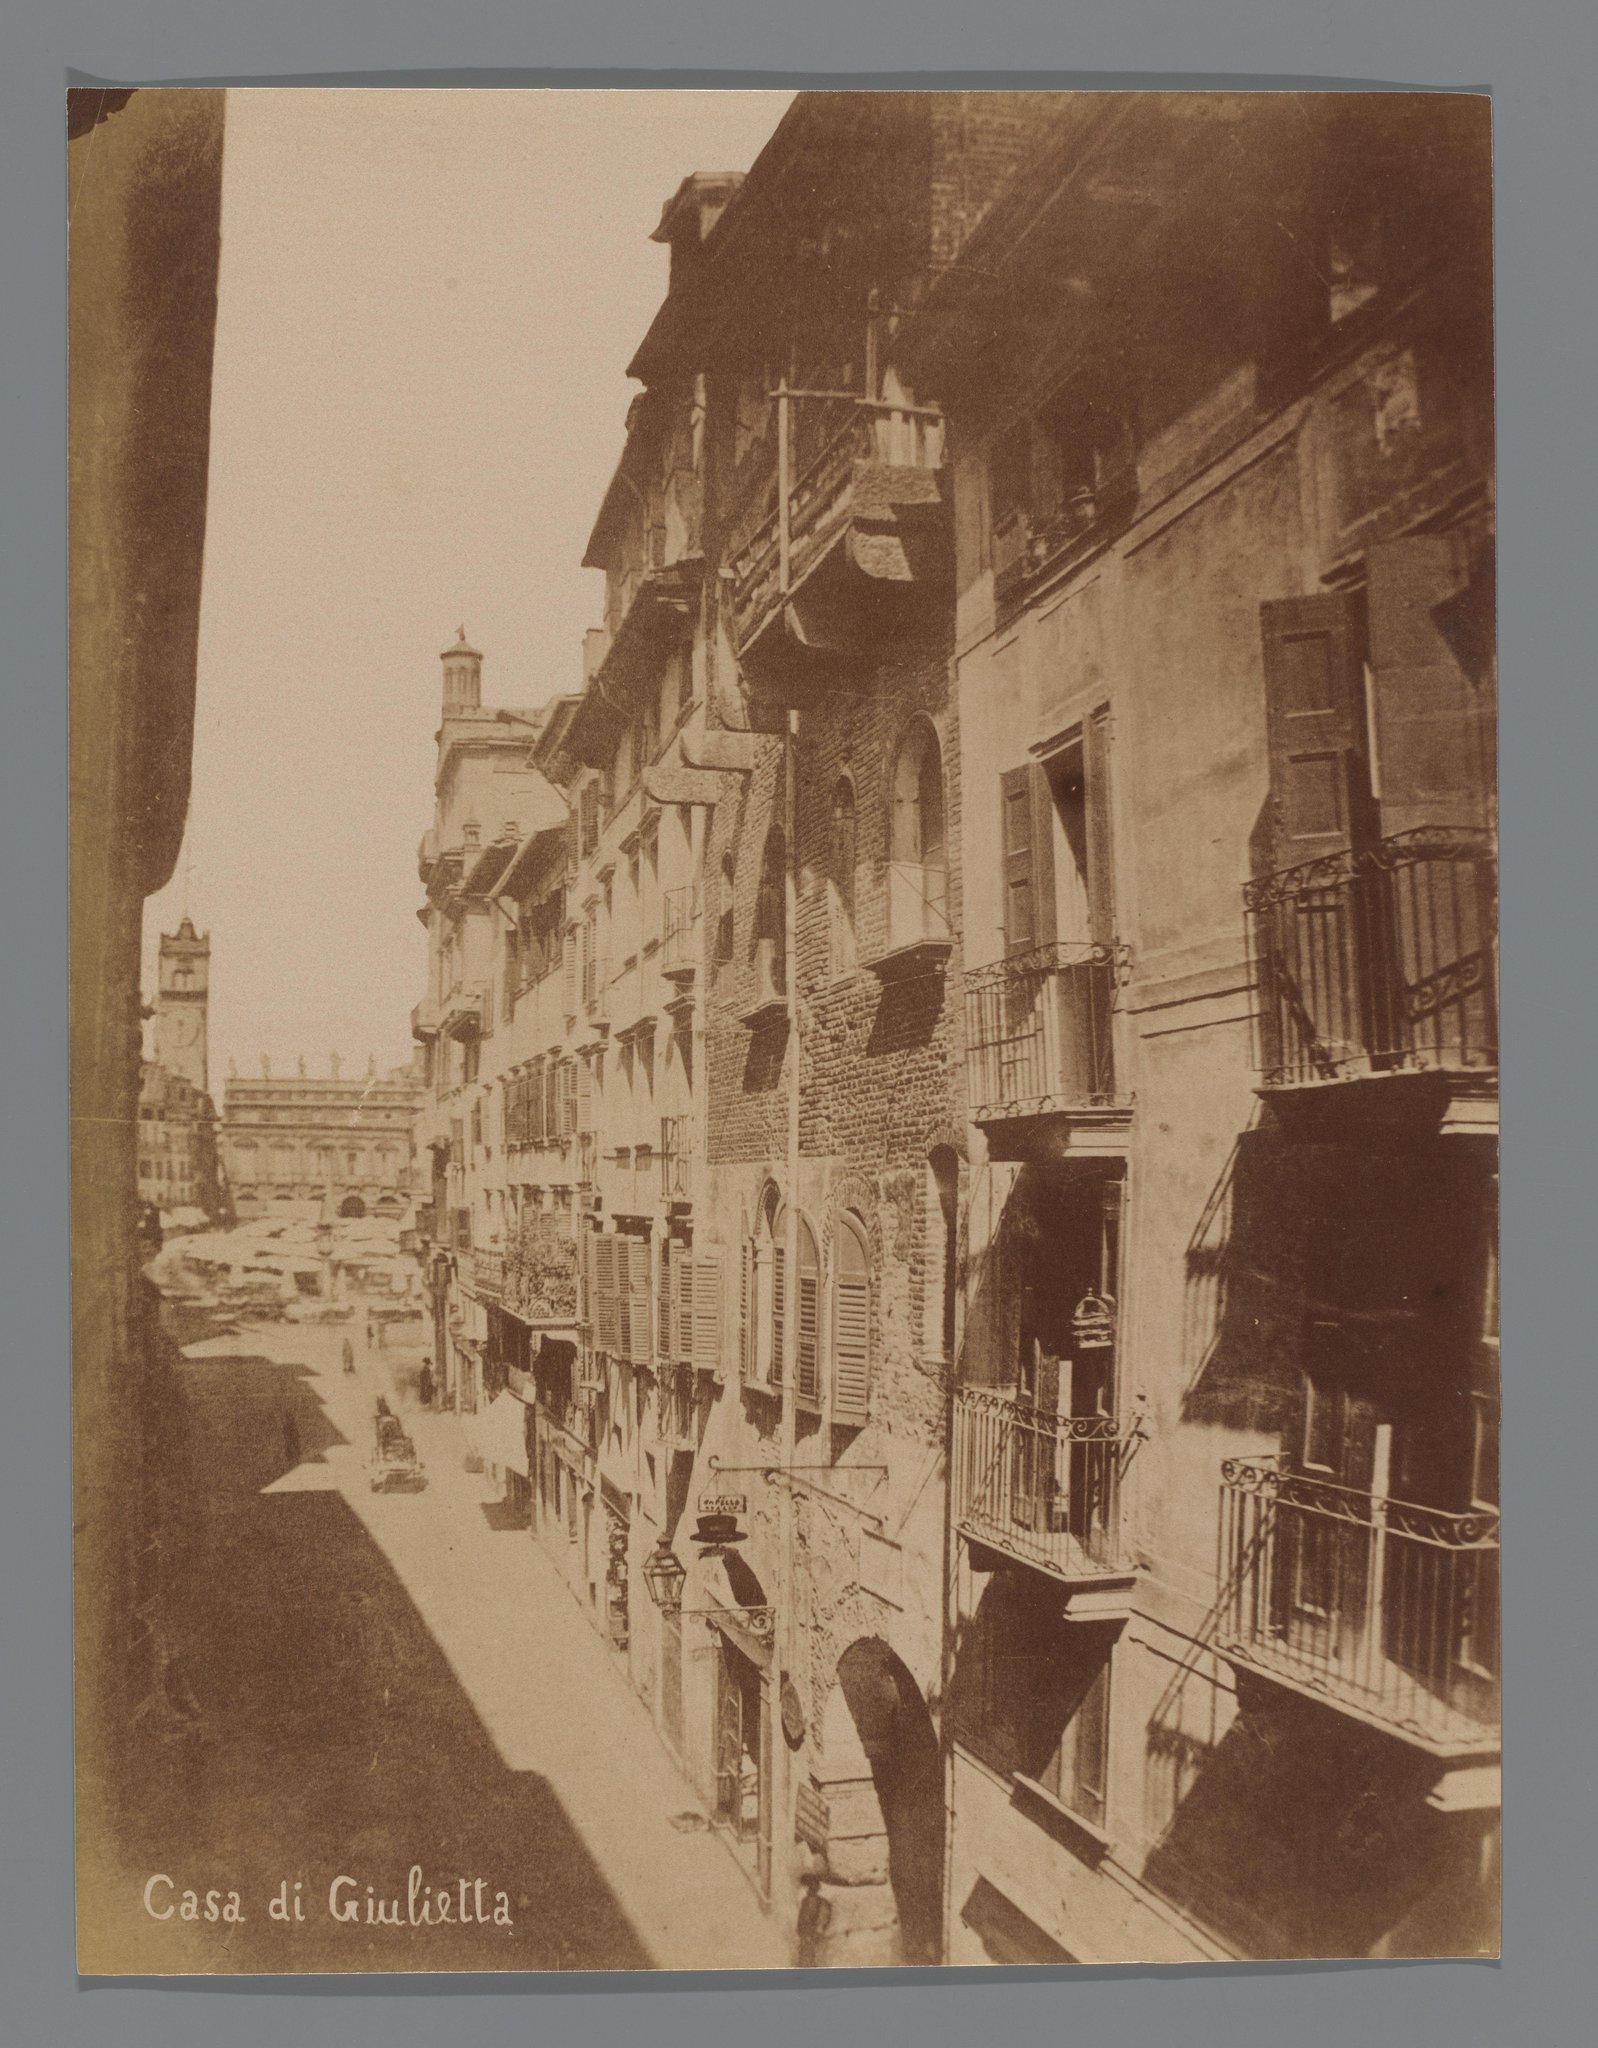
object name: photograph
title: Zicht in de Via Cappello met het huis van Julia te Verona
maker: Anonymous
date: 1851-1900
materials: paper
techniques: albumen print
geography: verona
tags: street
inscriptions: collector's mark: ‘VOSMAER’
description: Rechts een huis uit de veertiende eeuw dat Shakespeare zou hebben geïnspireerd tot het schrijven van de tragedie Romeo en Julia.